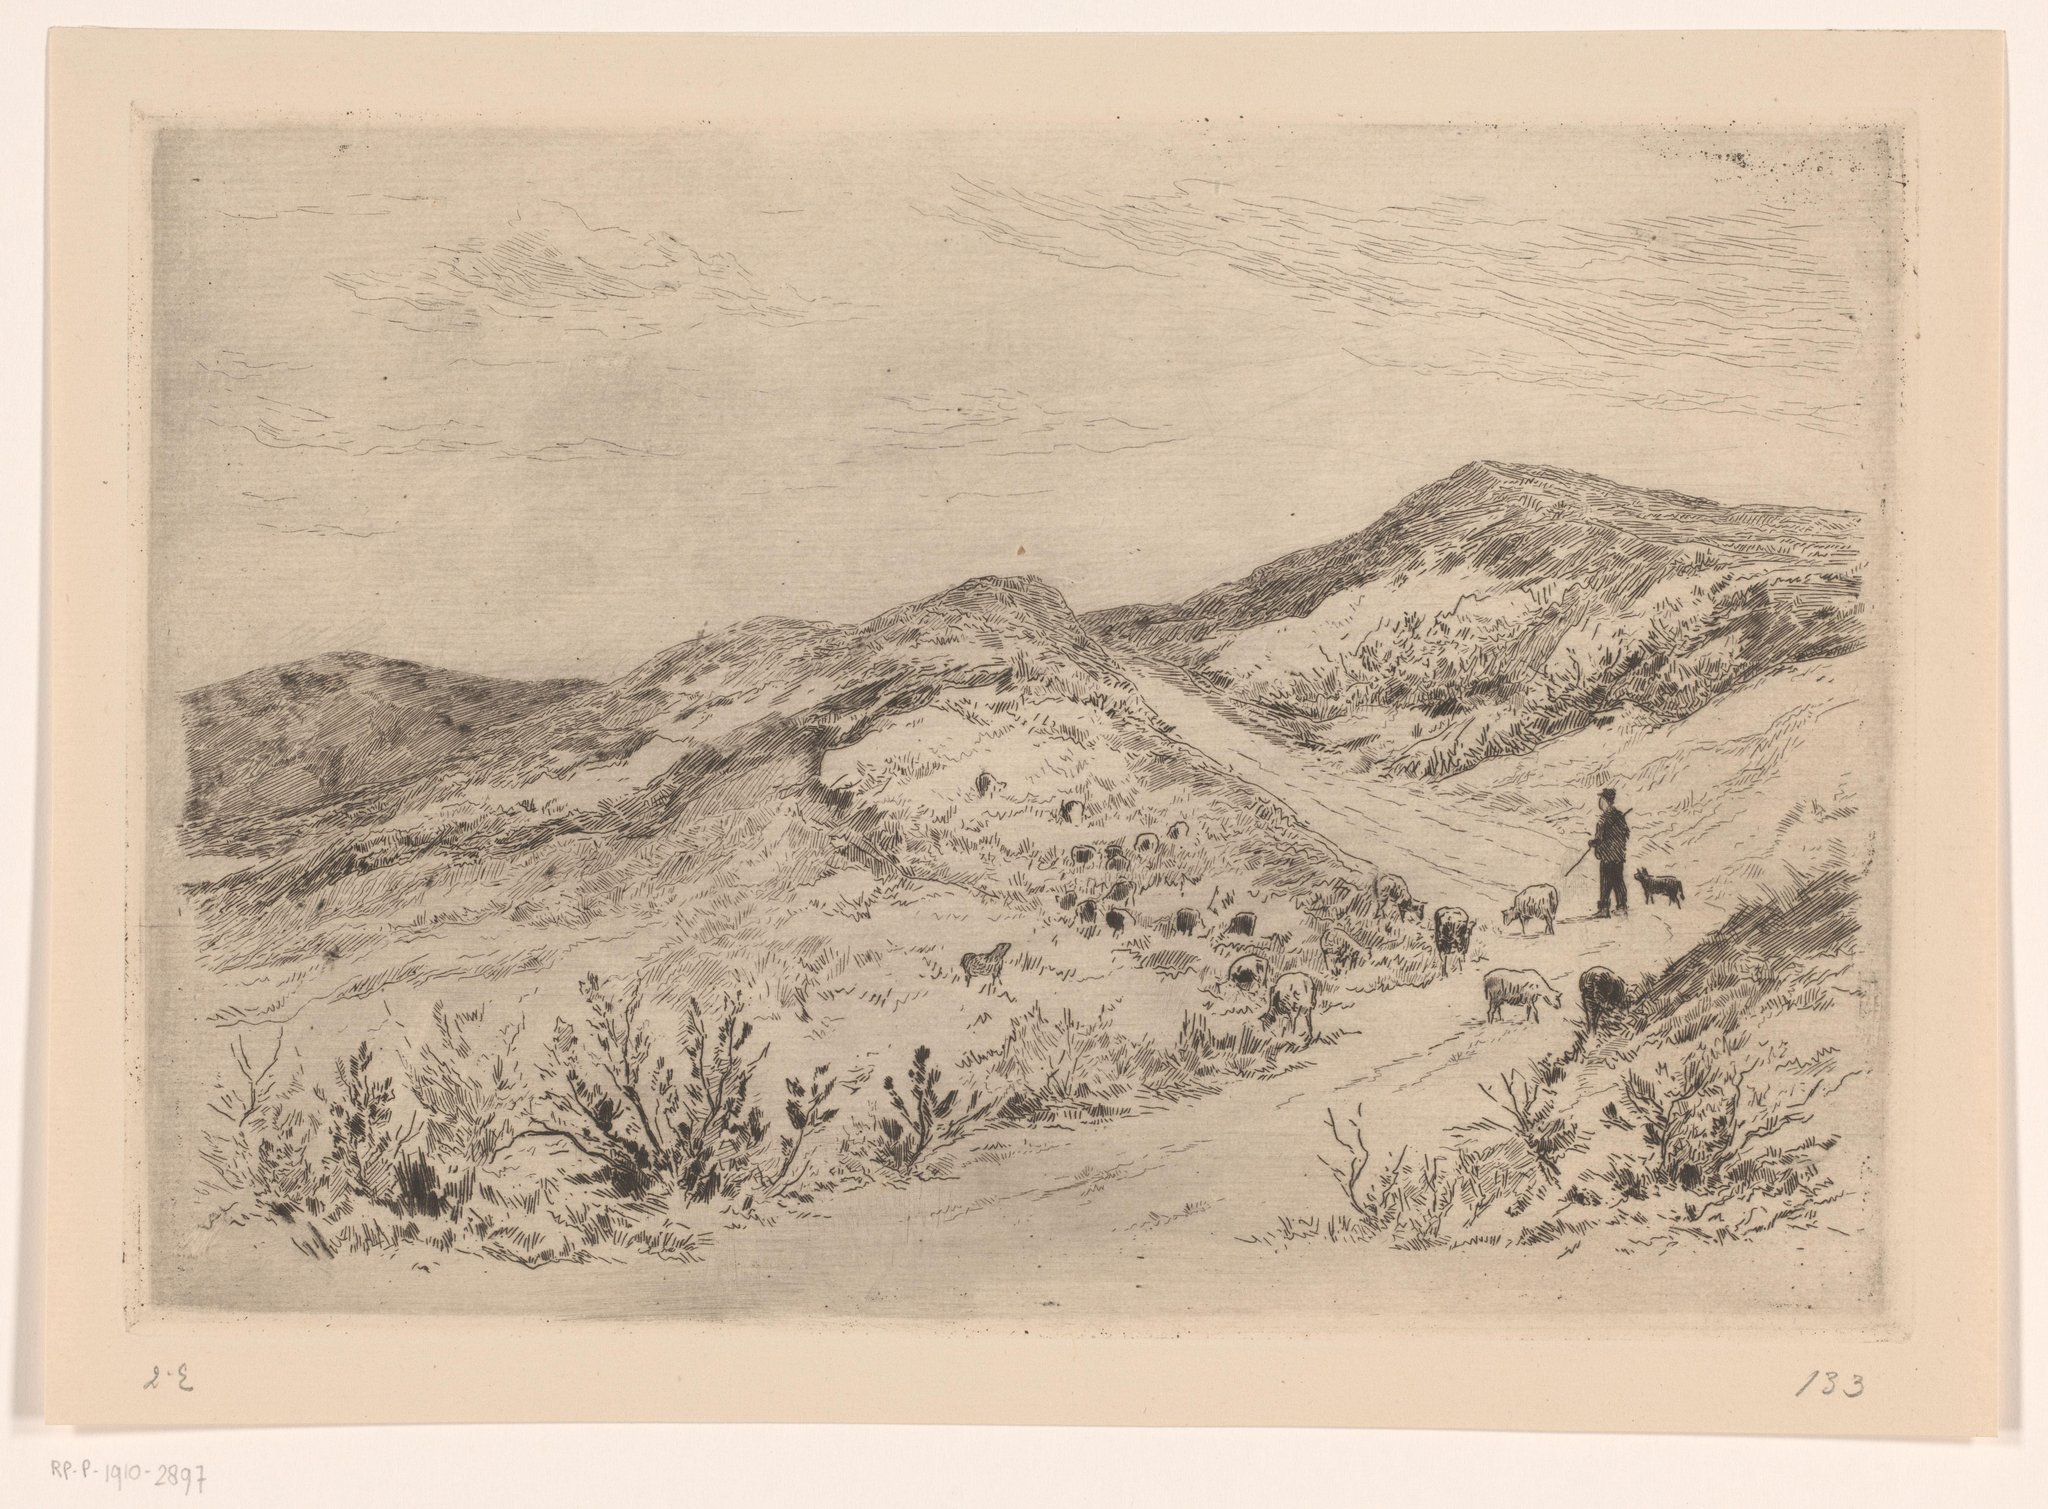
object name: print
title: Dans les hautes bruyères de Wordt-Rheden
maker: carel nicolaas storm van s-gravesande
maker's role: draughtsman, print maker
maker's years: 1841-1924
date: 1880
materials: paper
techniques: etching, intaglio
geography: netherlands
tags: low hill country (+ landscape with figures, staffage), herd, flock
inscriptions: collector's mark: Lugt 2228